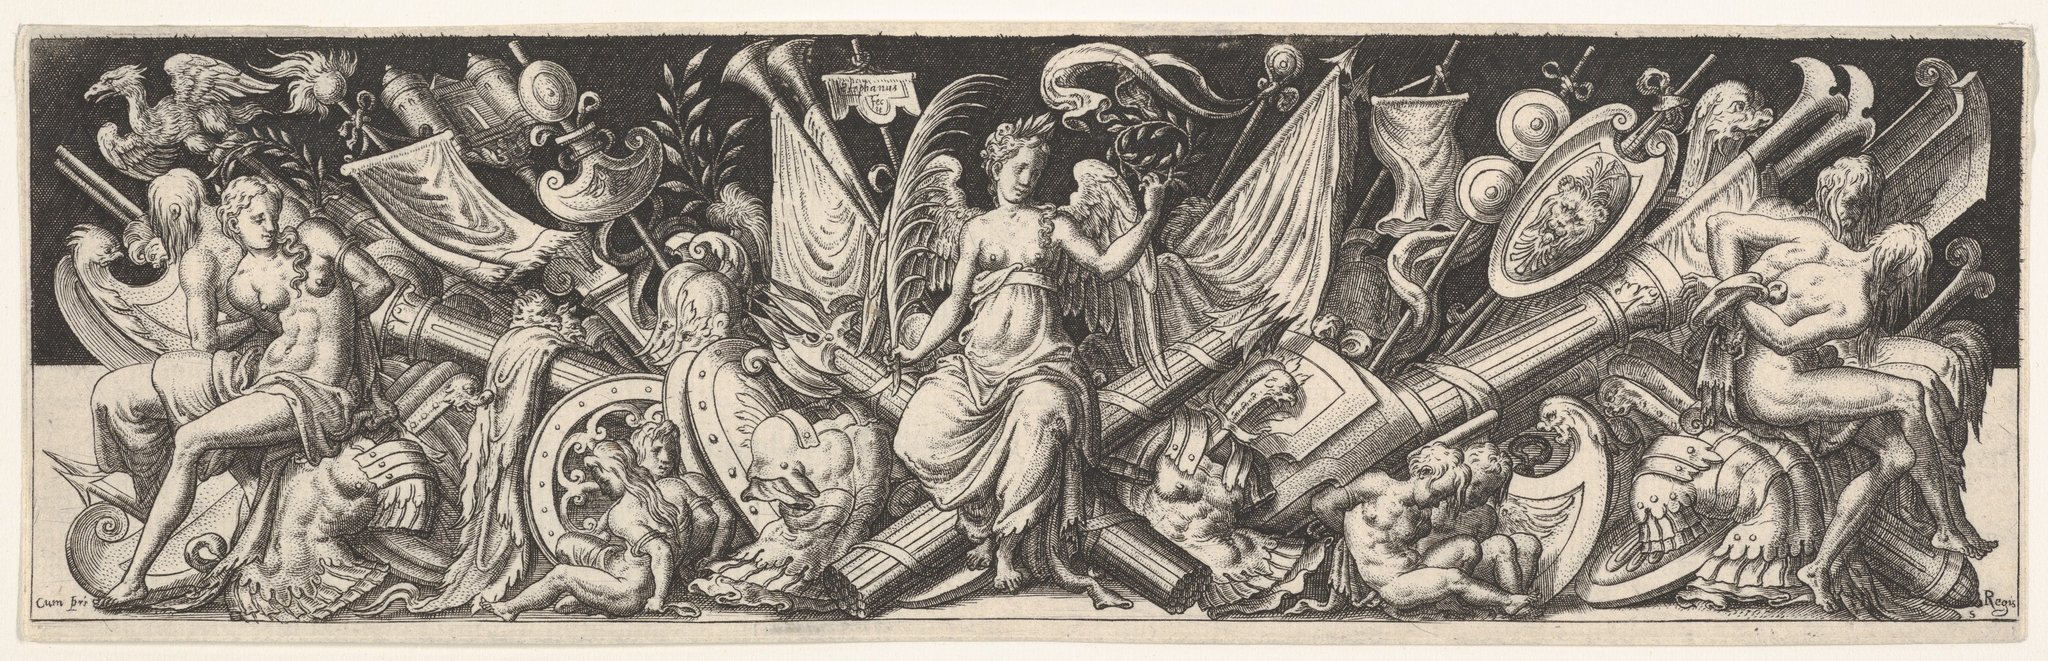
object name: print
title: Plate from "Battles and Victories" (Combats et Triomphes)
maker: etienne delaune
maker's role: artist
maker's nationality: french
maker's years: 1518-1583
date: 1540-1583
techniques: engraving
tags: weapons,female nudes